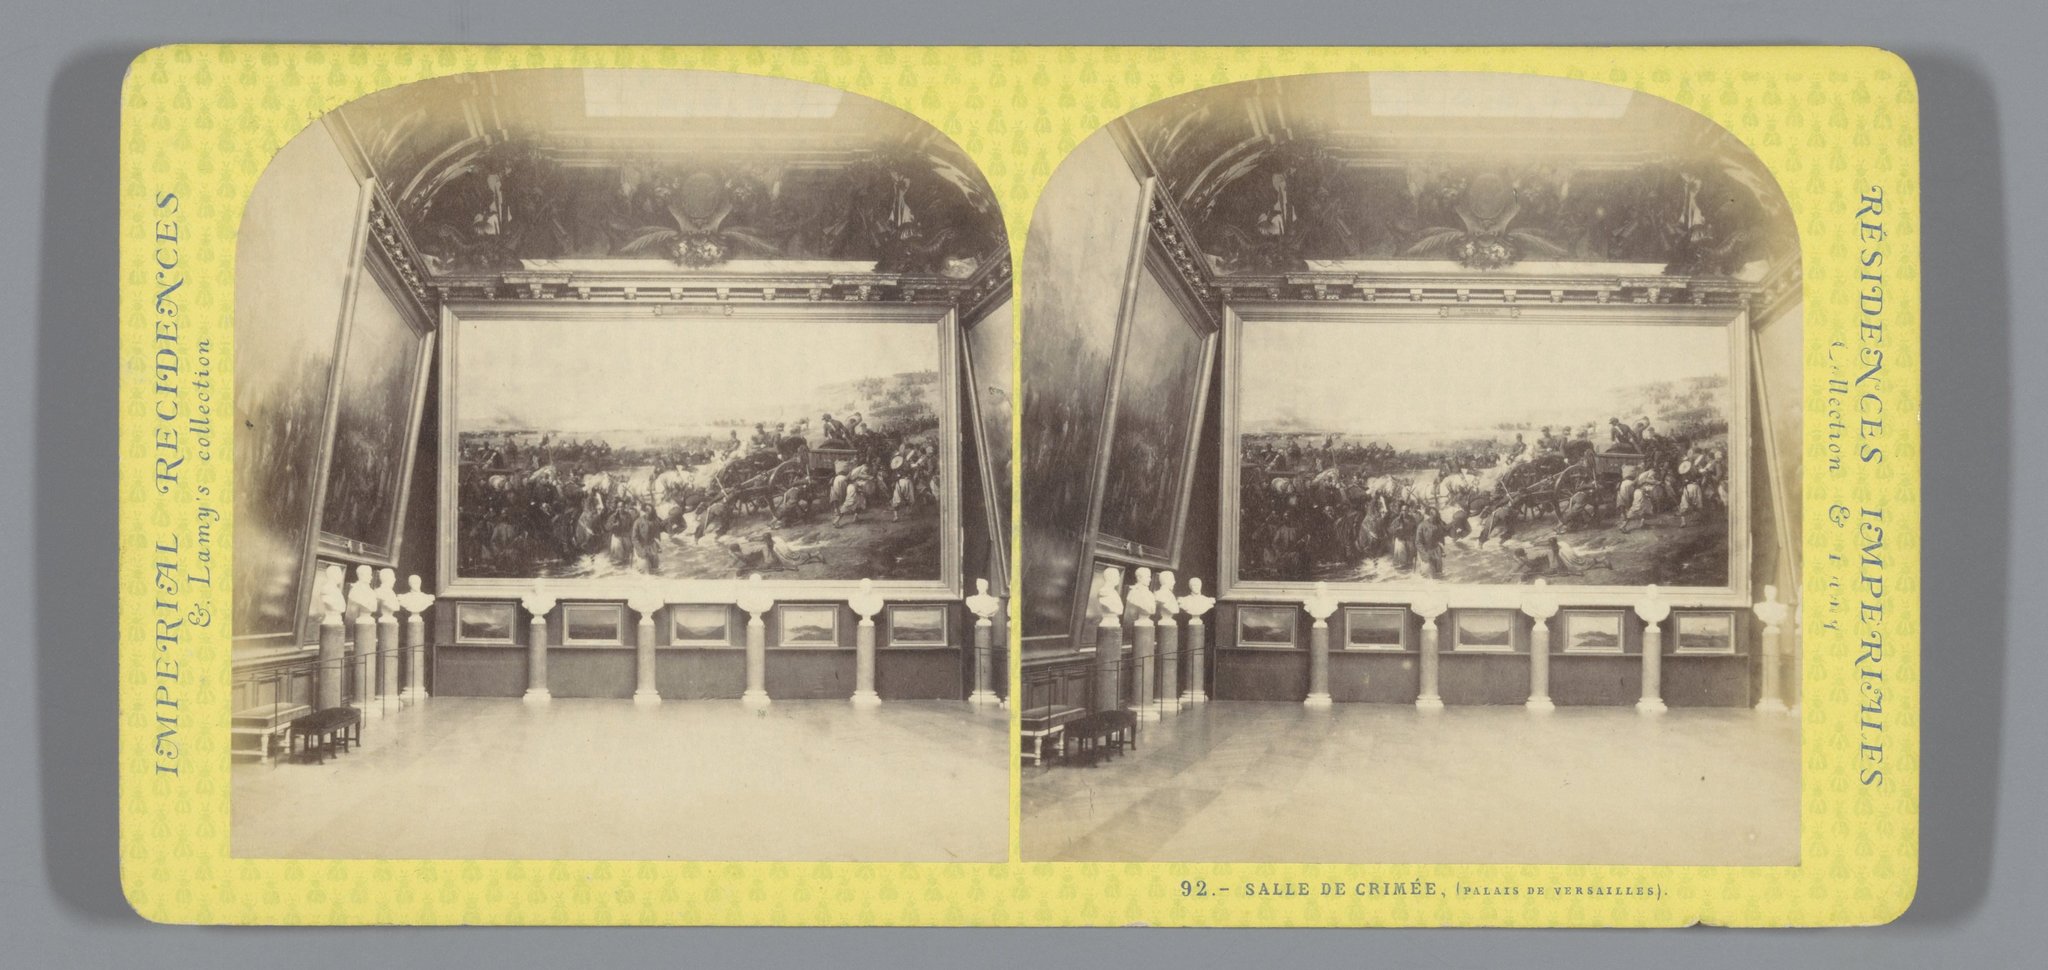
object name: stereograph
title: Schilderijengalerij in het paleis van Versailles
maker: ernest eléonor pierre lamy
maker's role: publisher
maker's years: 1828-1900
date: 1860-1880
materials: cardboard, photographic support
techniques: albumen print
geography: versailles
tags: picture, painting, interior ~ representation of a building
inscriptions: inscription: ‘E. Lamy's collection’, number: ‘92.’